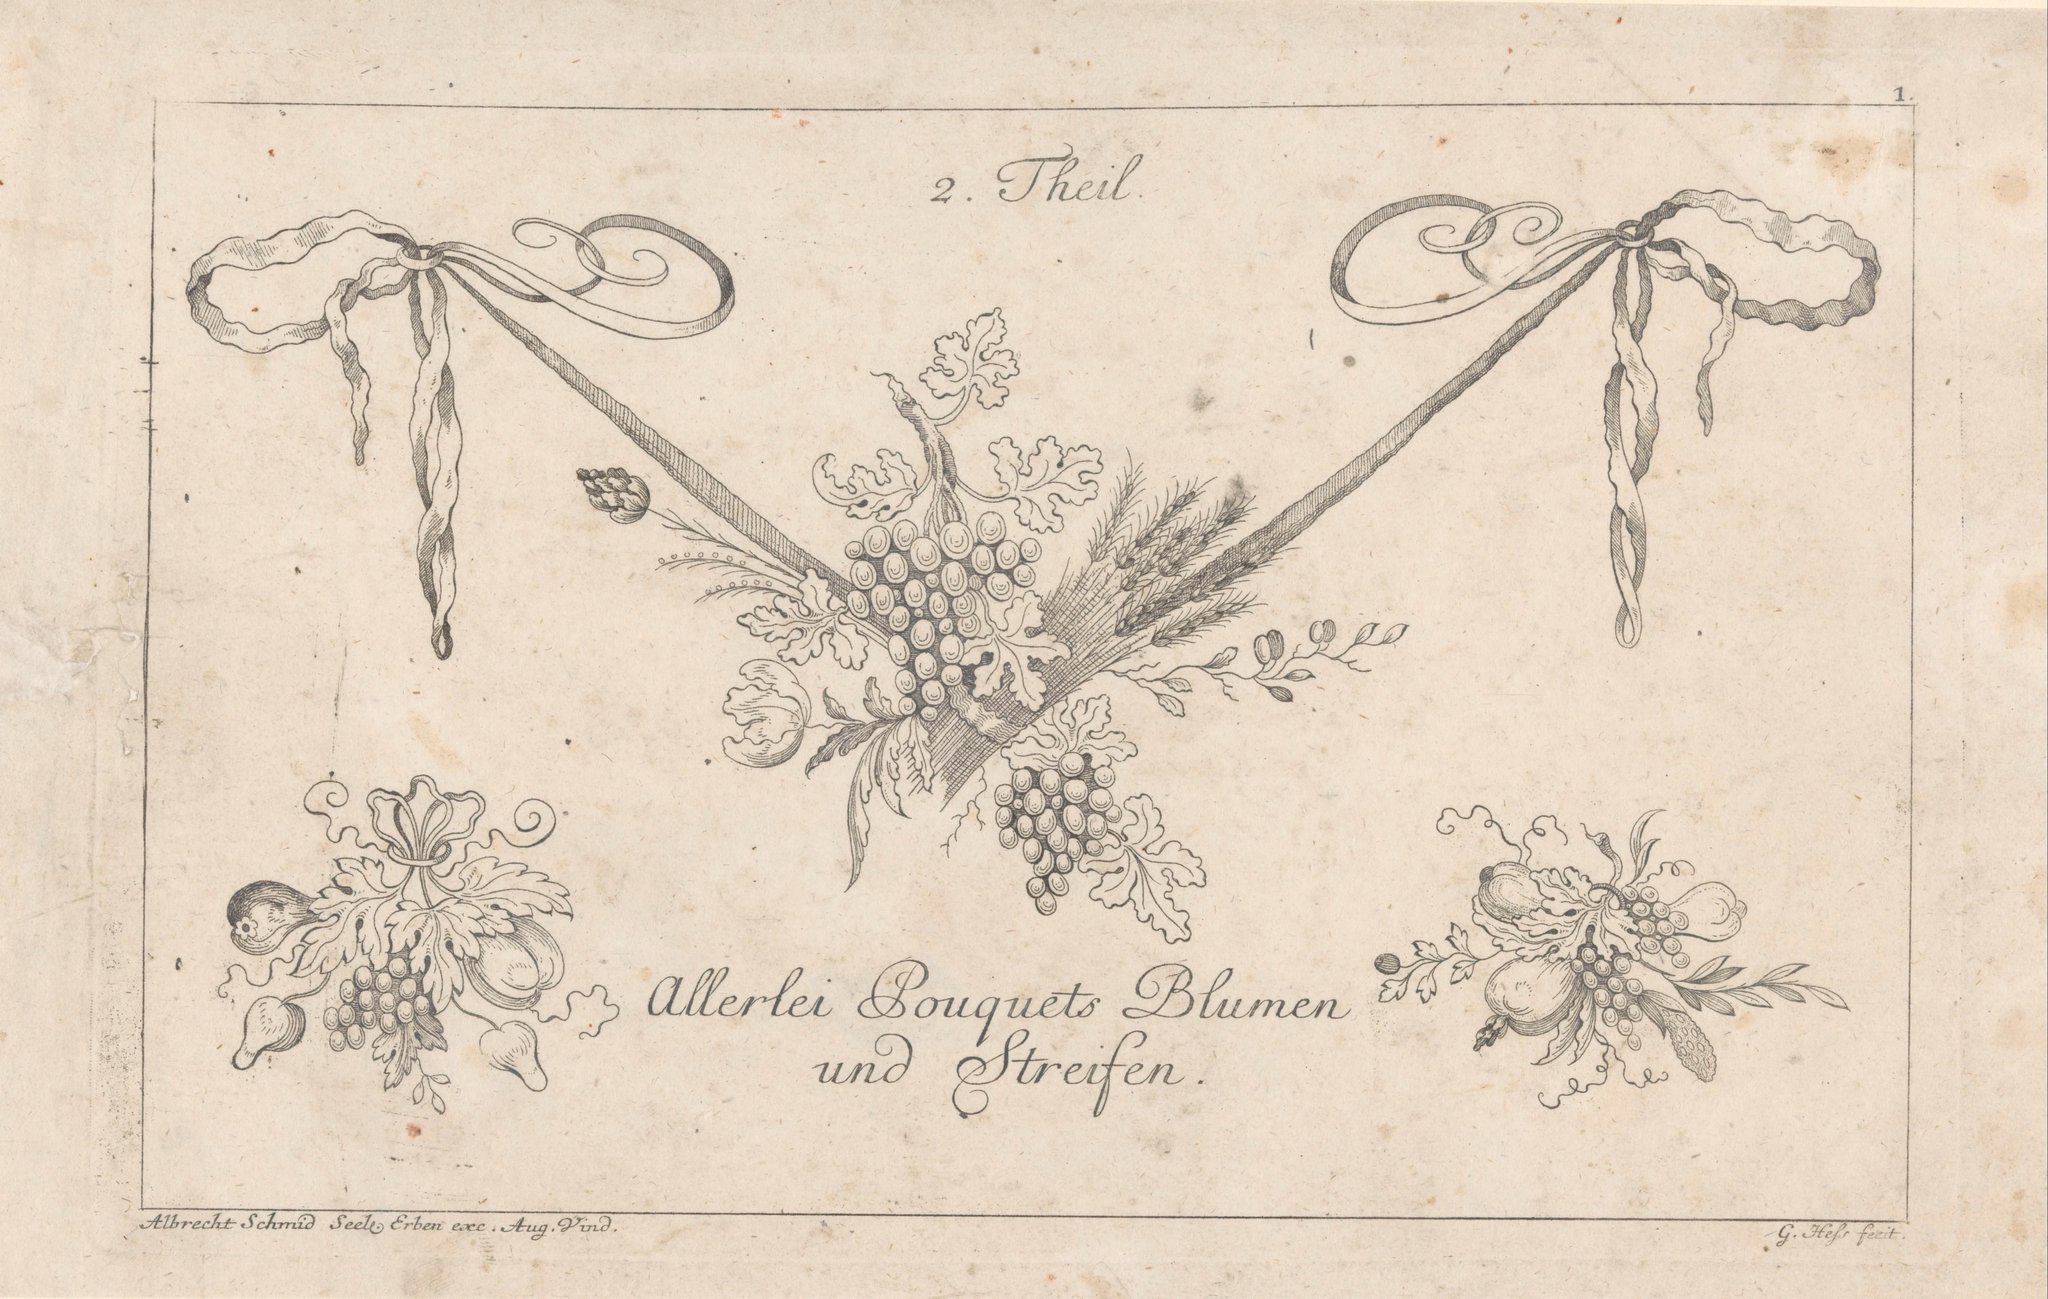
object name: print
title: Bloemen en fruit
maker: gottlieb hess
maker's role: publisher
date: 1744-1800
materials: paper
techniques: etching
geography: augsburg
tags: fruits and vegetables ~ ornament, bunch of grapes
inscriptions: collector's mark: Lugt 2228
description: Ontwerpen voor diverse bloemen en fruit. In het midden druiventrossen, bloemen en aren met linten links en rechts. Links- en rechts onder druiventrossen en ander fruit.